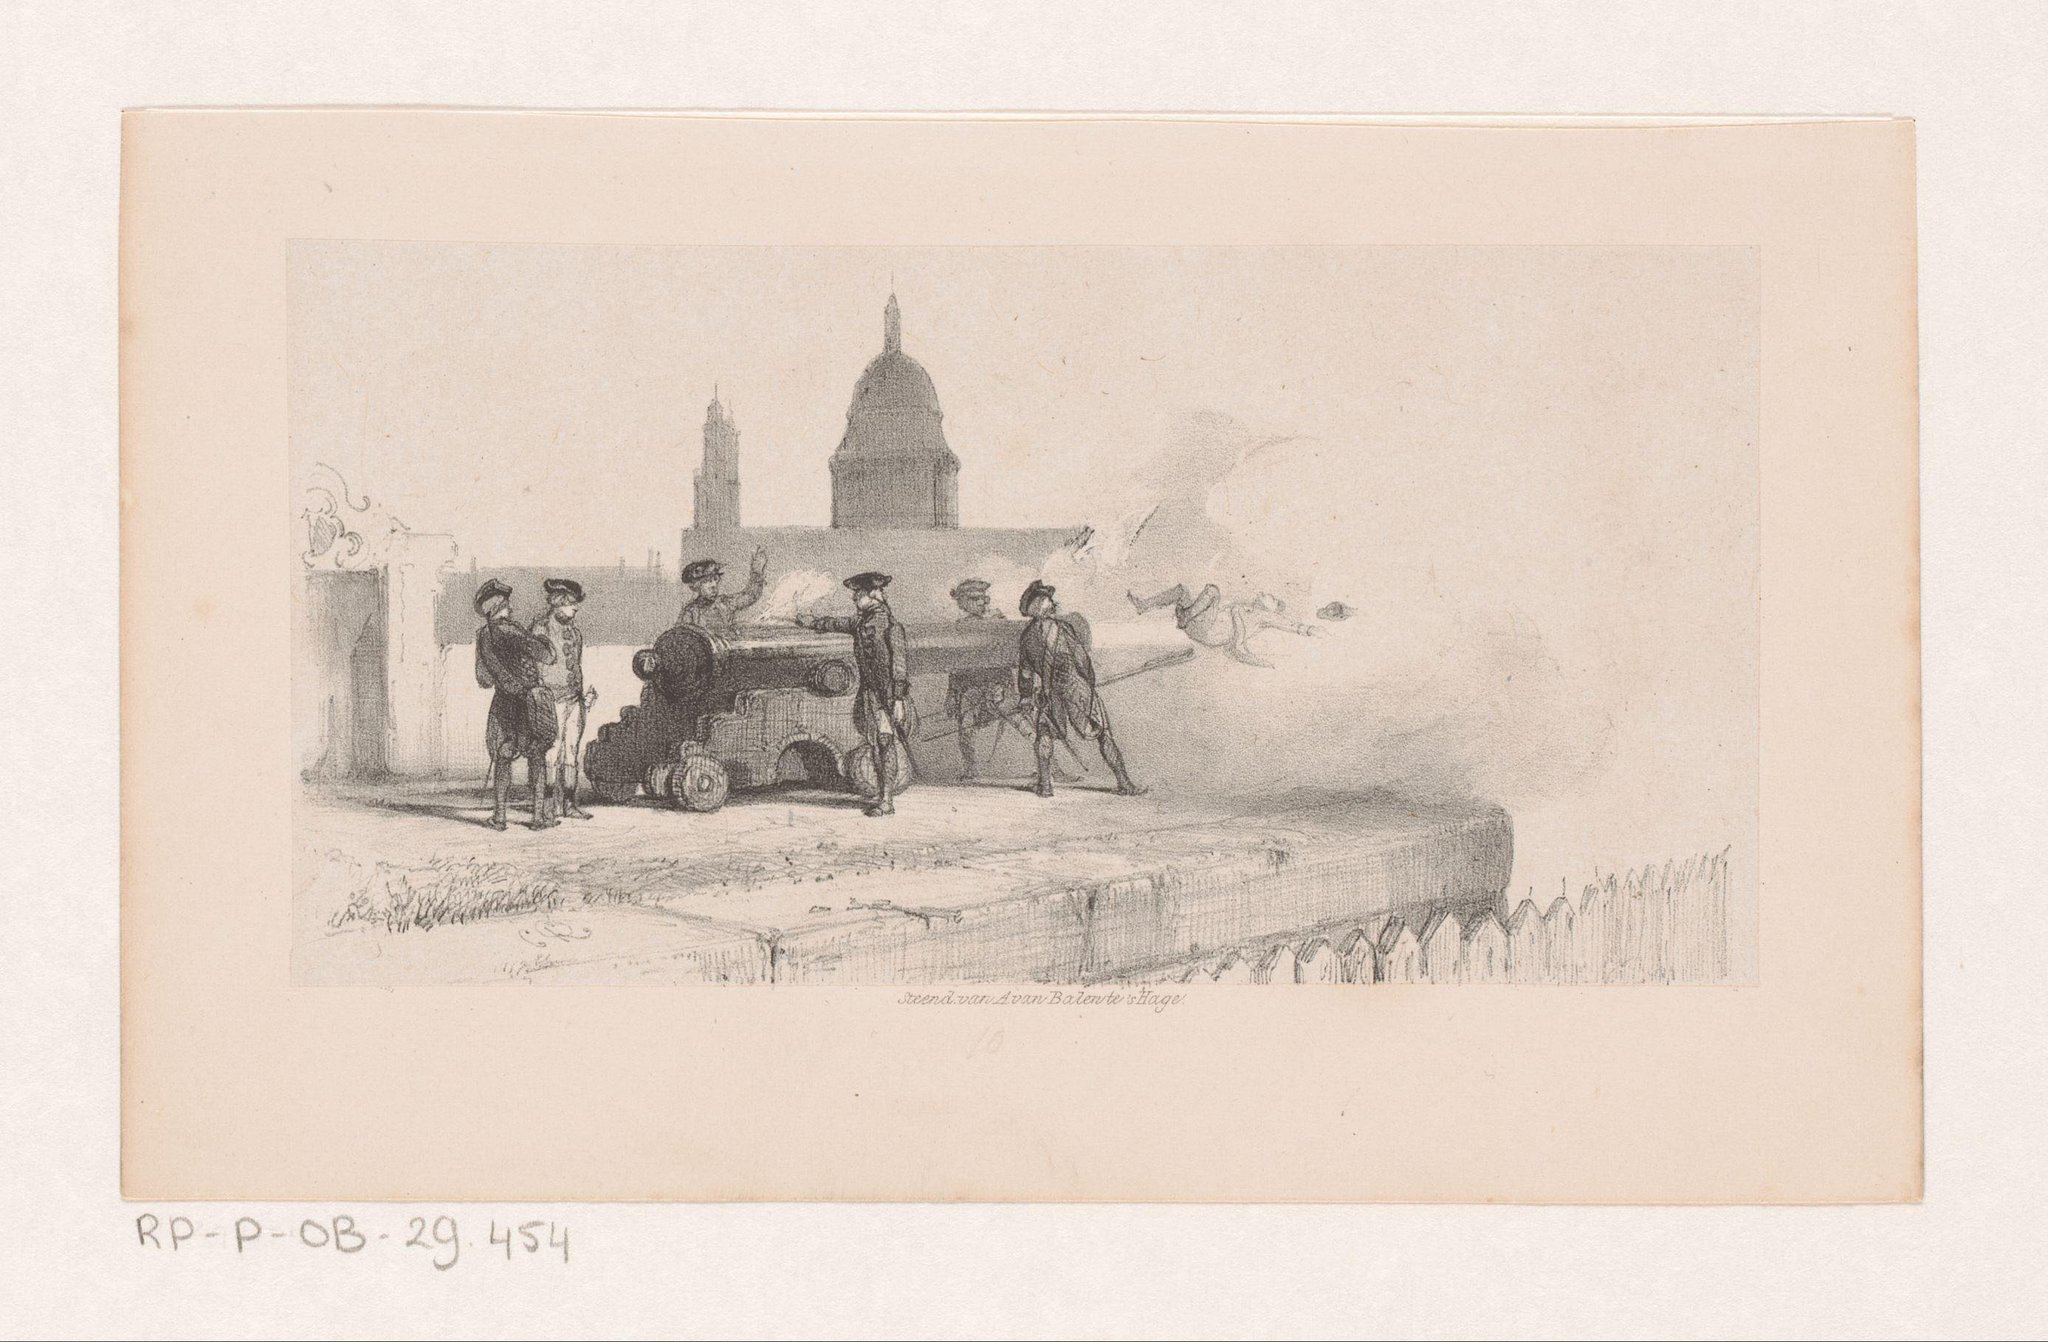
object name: print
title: Mannen vuren kanon af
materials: paper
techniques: lithograph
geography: the hague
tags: baron münchausen, firearms: cannon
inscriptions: collector's mark: Lugt 2228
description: Een groep mannen vuurt een kanon af. Voor de kanon vliegt een man de lucht in. Mogelijk het volksverhaal van Karl Friedrich Hieronymus Baron von Münchhausen die op een afgeschoten kanonskogel springt om in een belegerde stad te komen en de vijand te bespioneren en de stadspoort van binnenuit te openen.